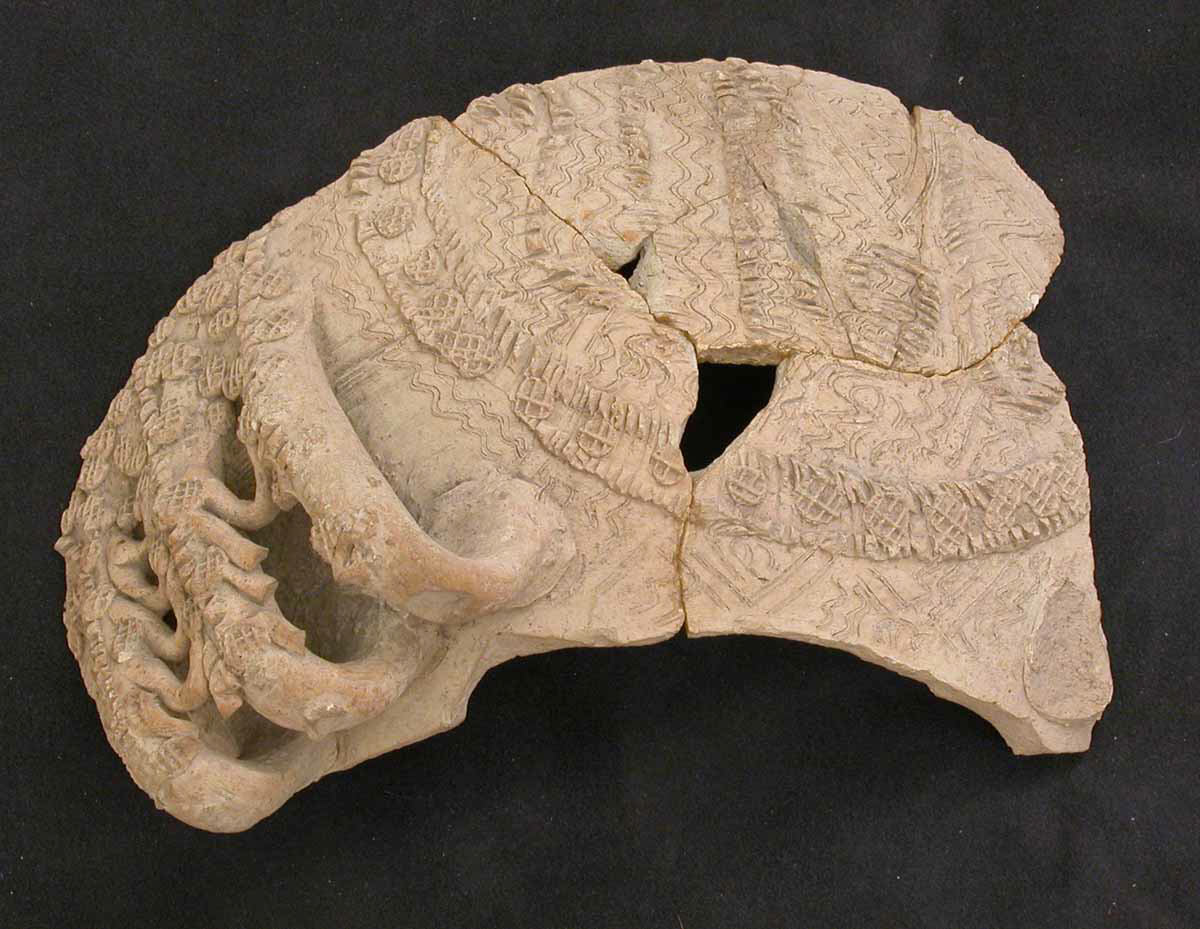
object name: fragment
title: Fragment of a Jar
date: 801-1000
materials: earthenware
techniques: incising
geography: iran